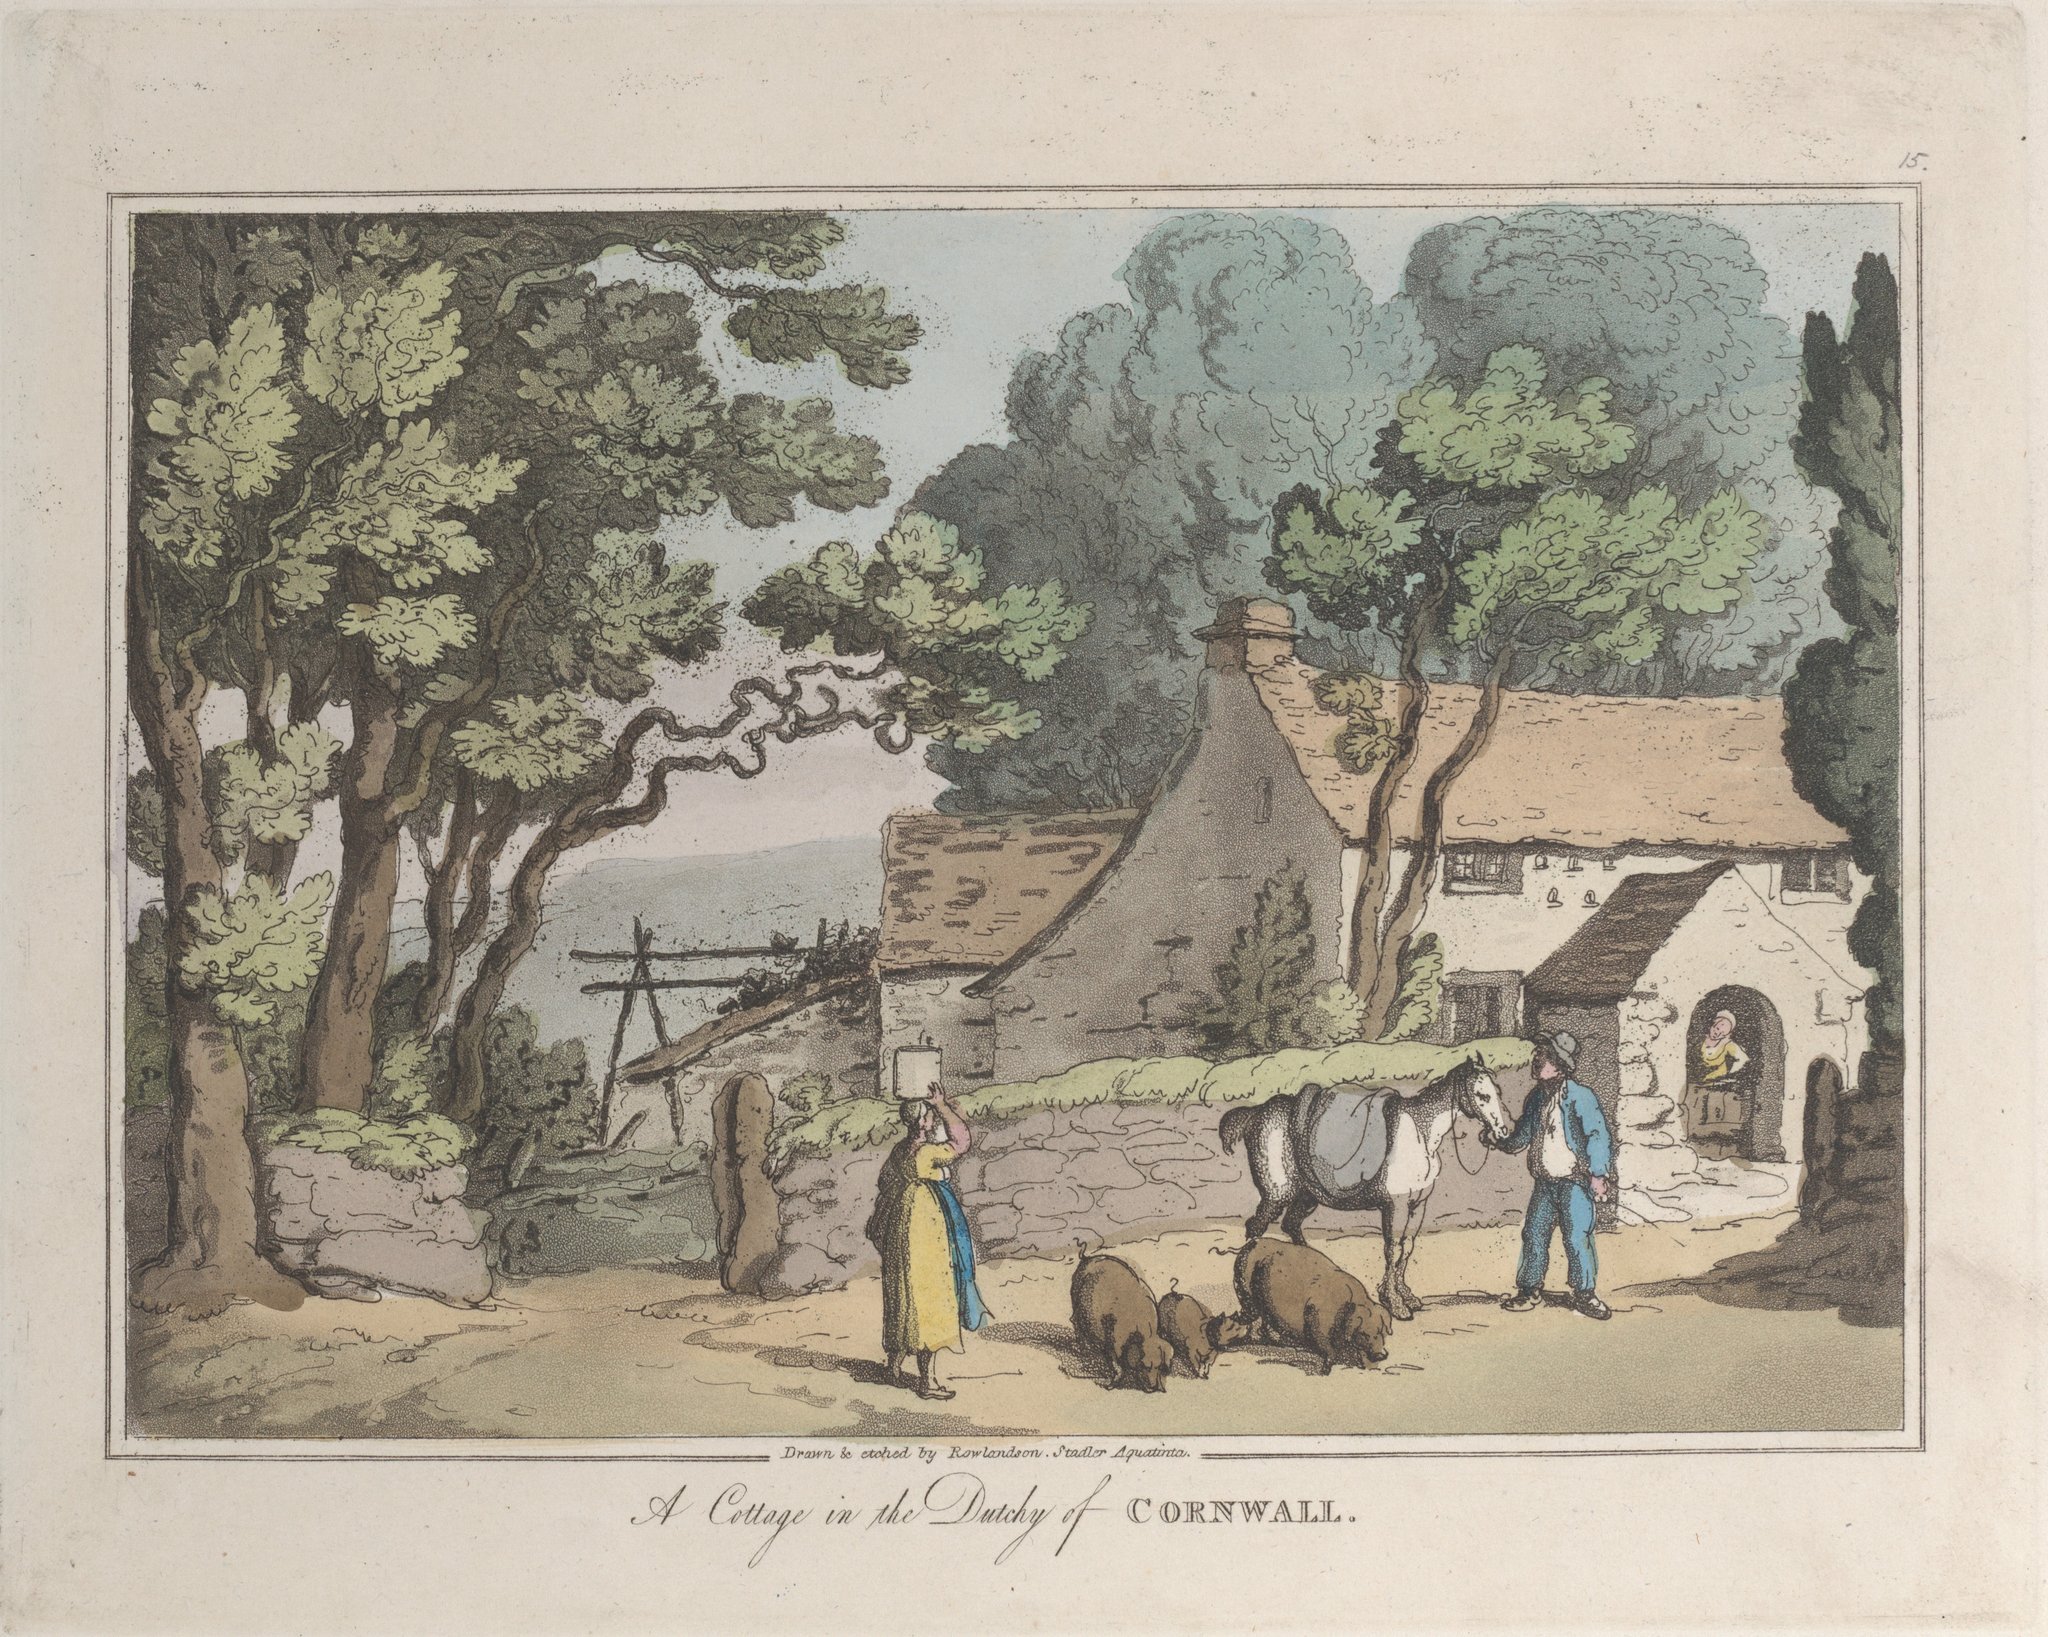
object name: print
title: A Cottage in the Dutchy of Cornwall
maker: thomas rowlandson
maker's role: artist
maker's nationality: british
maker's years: 1757-1827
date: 1822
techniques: aquatint, etching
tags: houses,men,women,horses,pigs